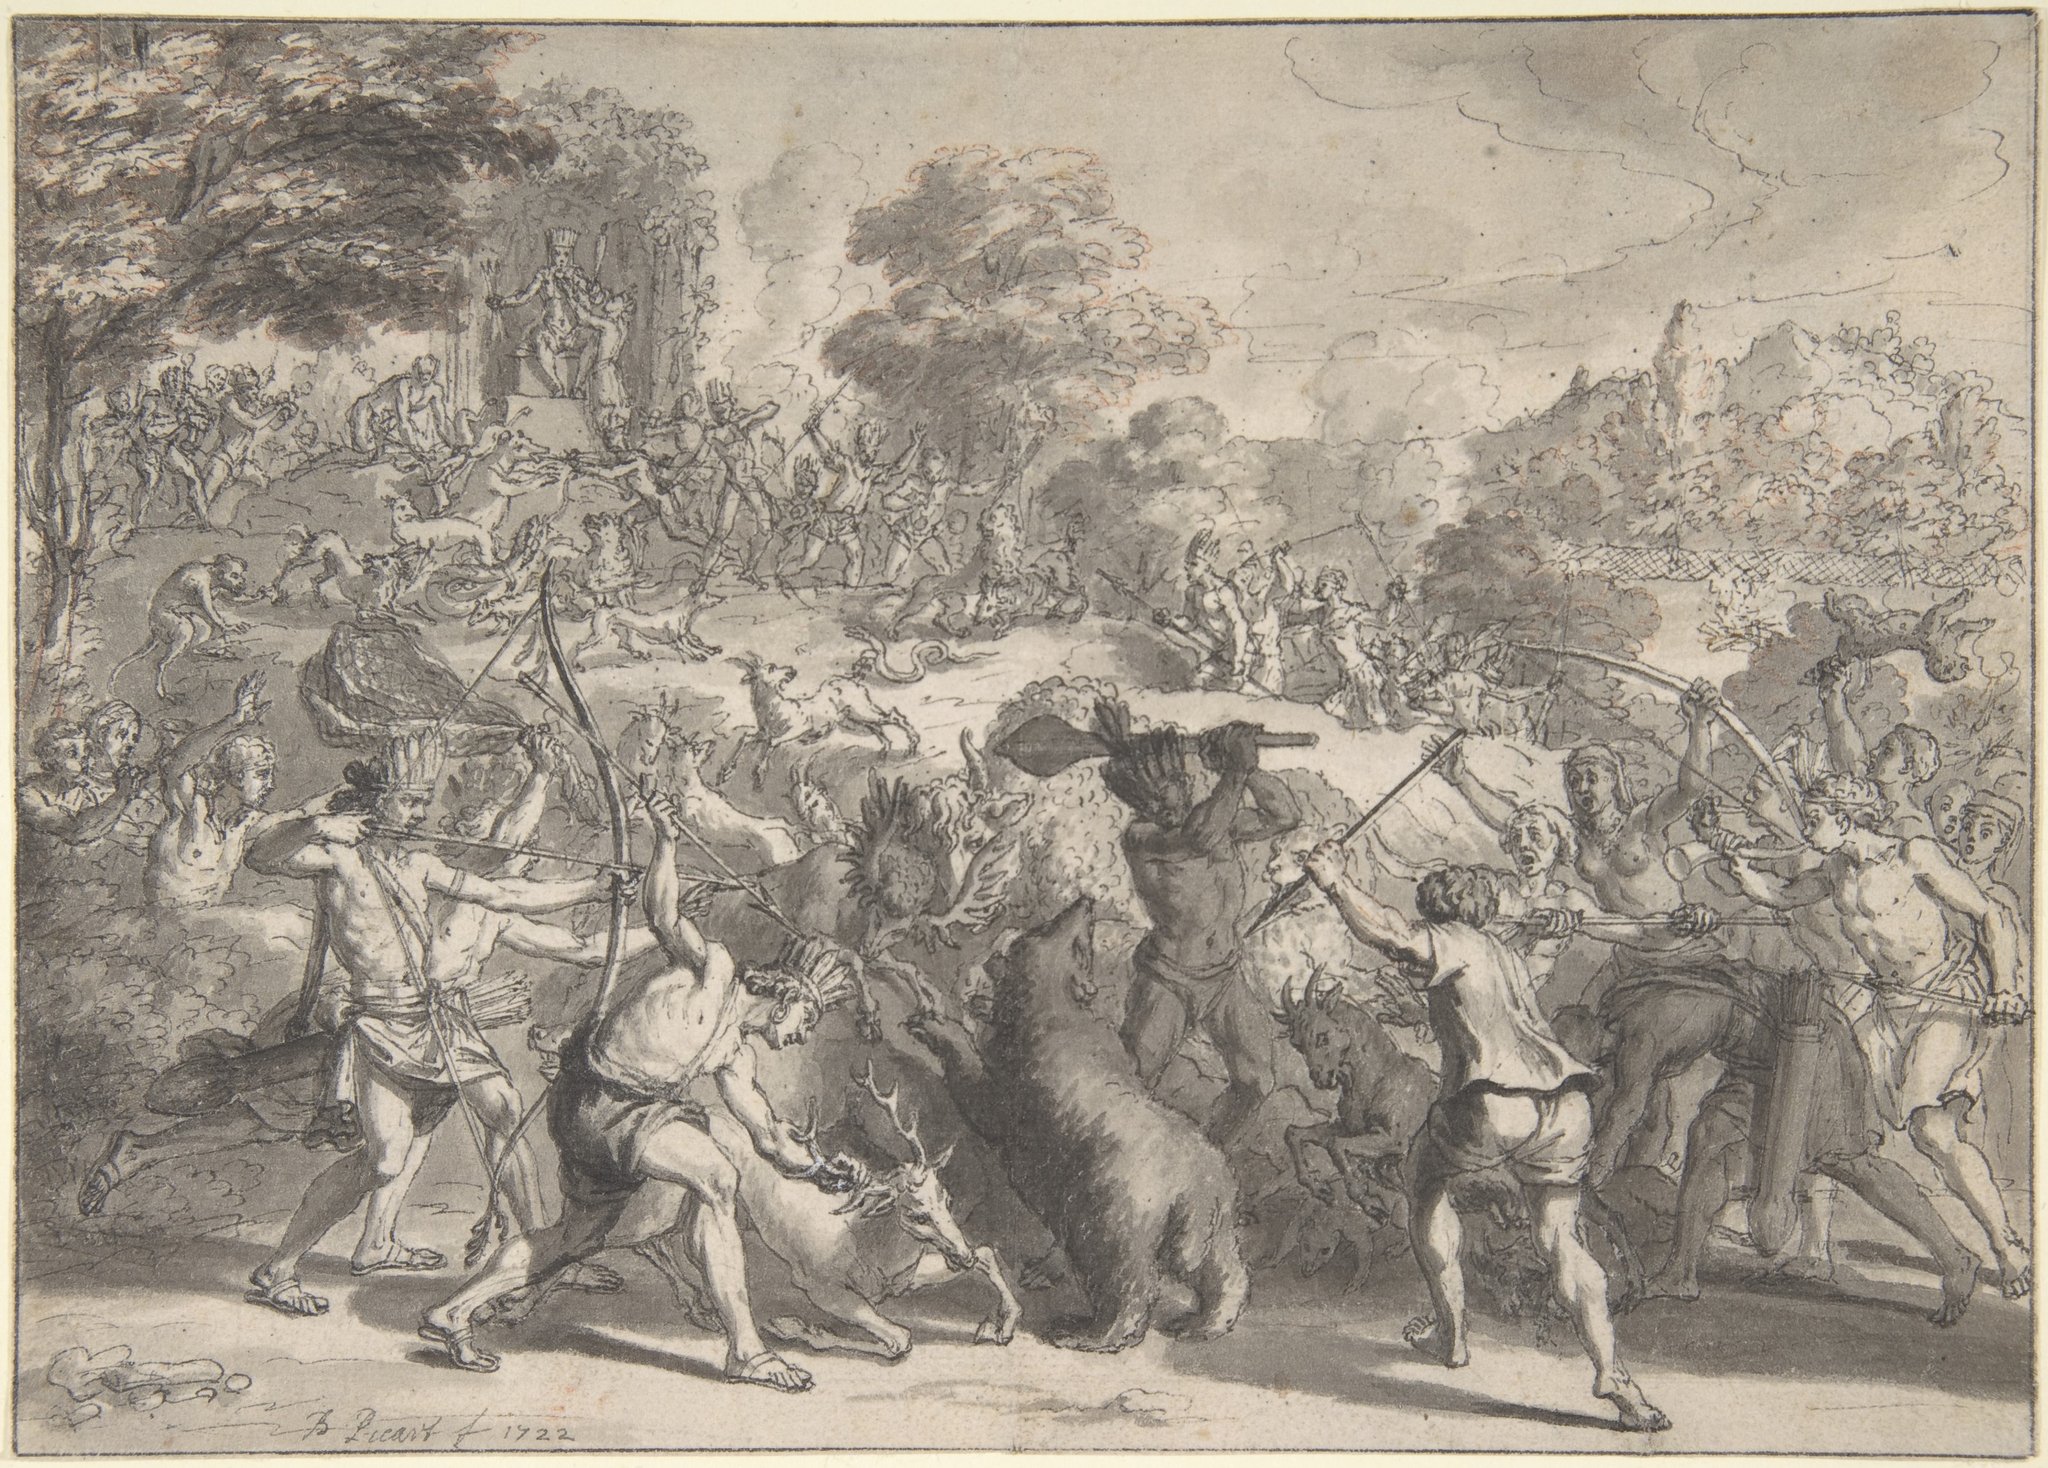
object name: drawing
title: Mexican Sacrifice to the God of Hunting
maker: bernard picart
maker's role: artist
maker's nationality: french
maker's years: 1673-1733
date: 1722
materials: chalk, graphite, ink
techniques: brush, heightening, incising, pen, transfer, wash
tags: bears,bow and arrow,men,hunting,deer